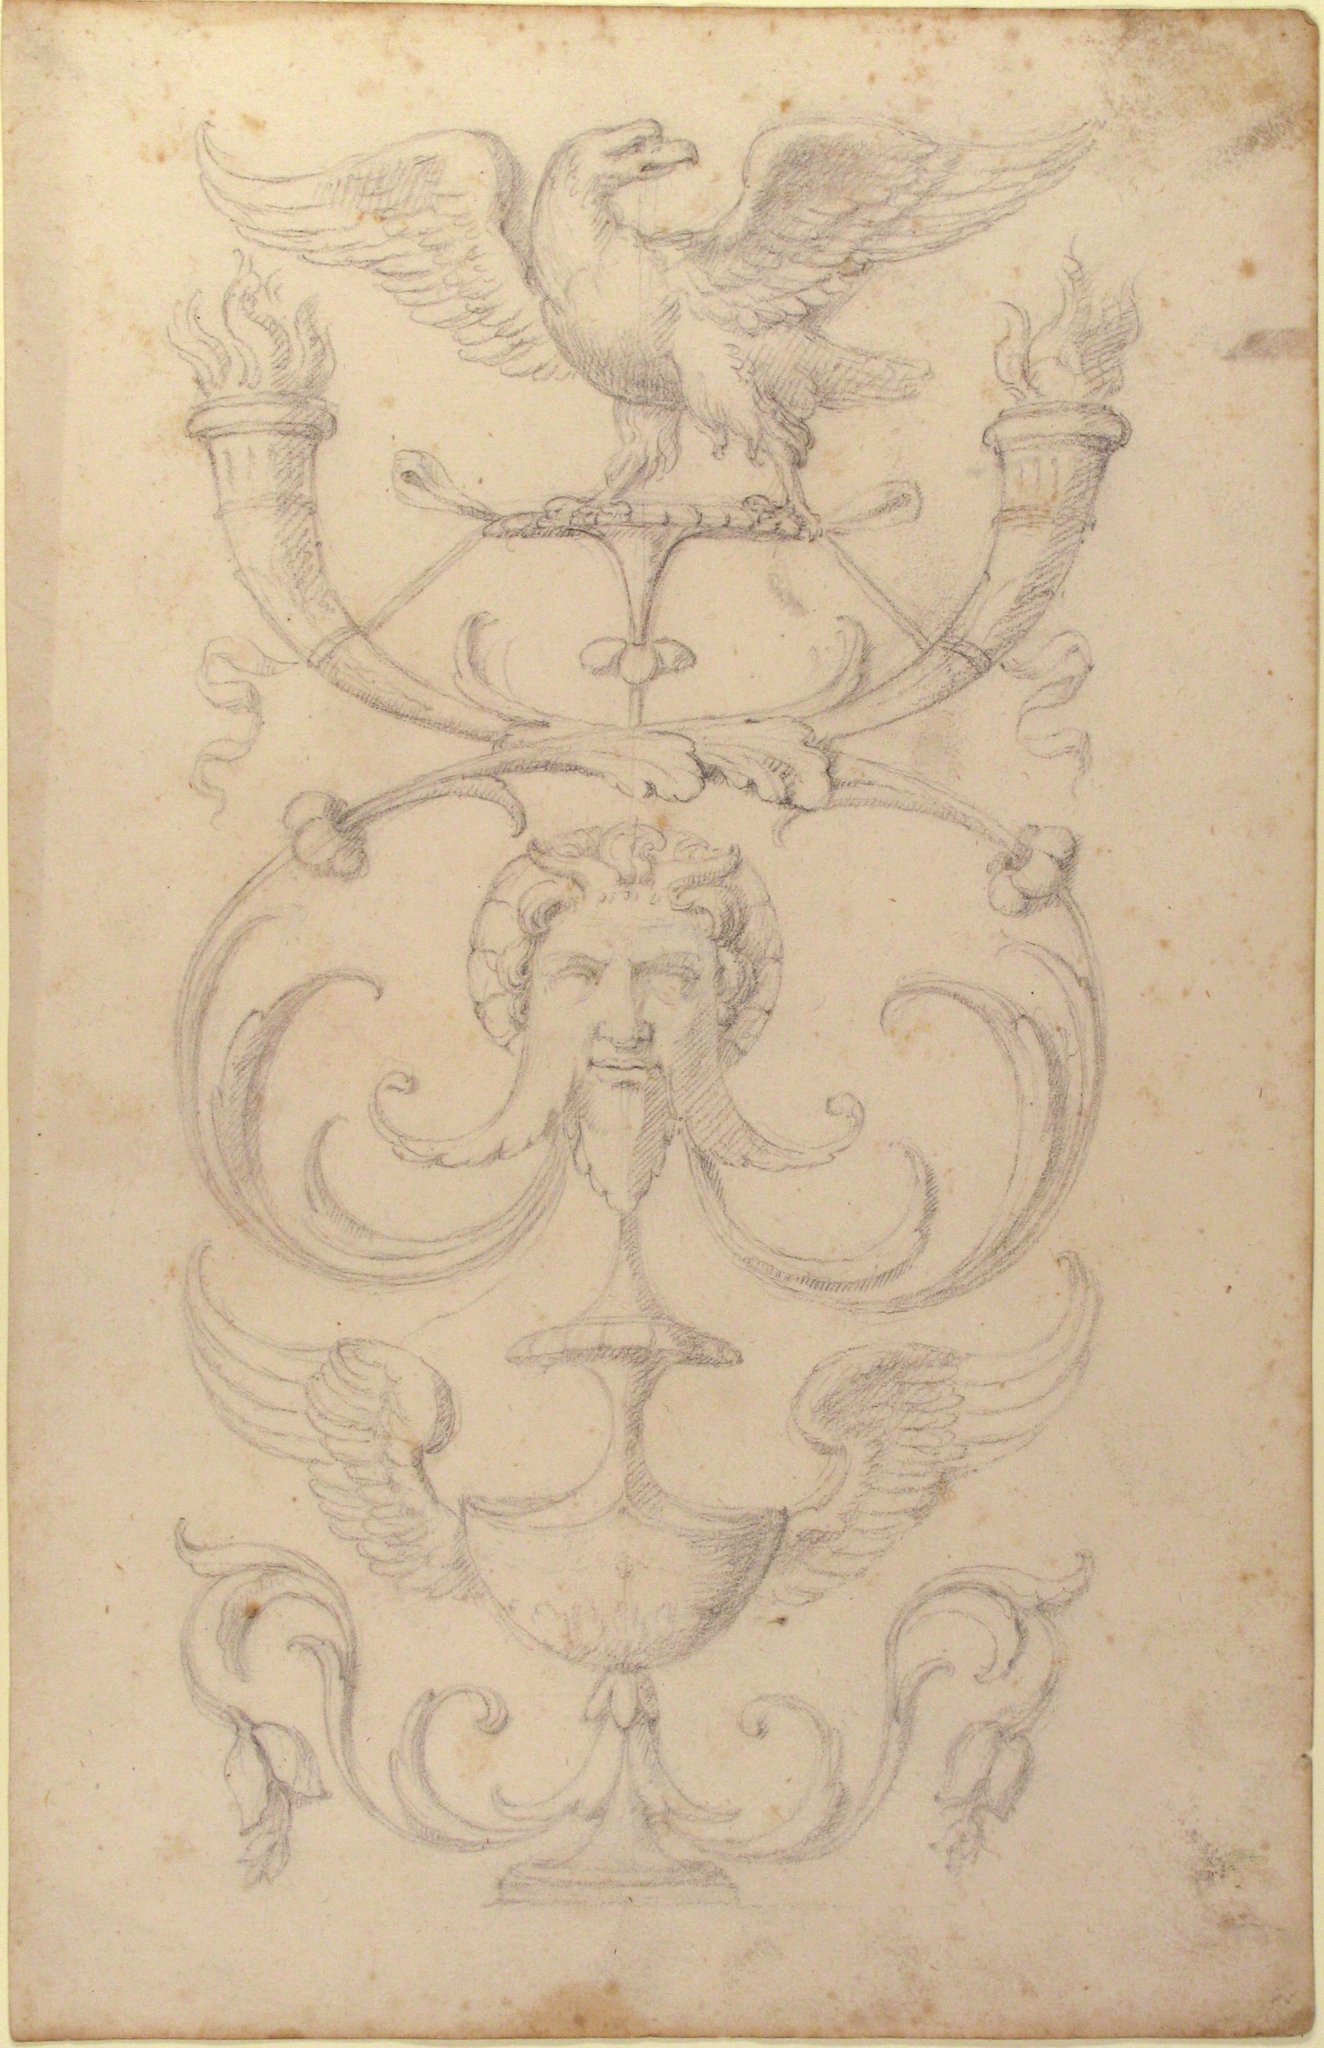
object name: drawing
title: Drawing of a Grotesque after a 16th-century Decorative Relief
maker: filippo cretoni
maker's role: artist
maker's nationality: italian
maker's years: 18-19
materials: chalk, graphite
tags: eagles,grotesques,ornament